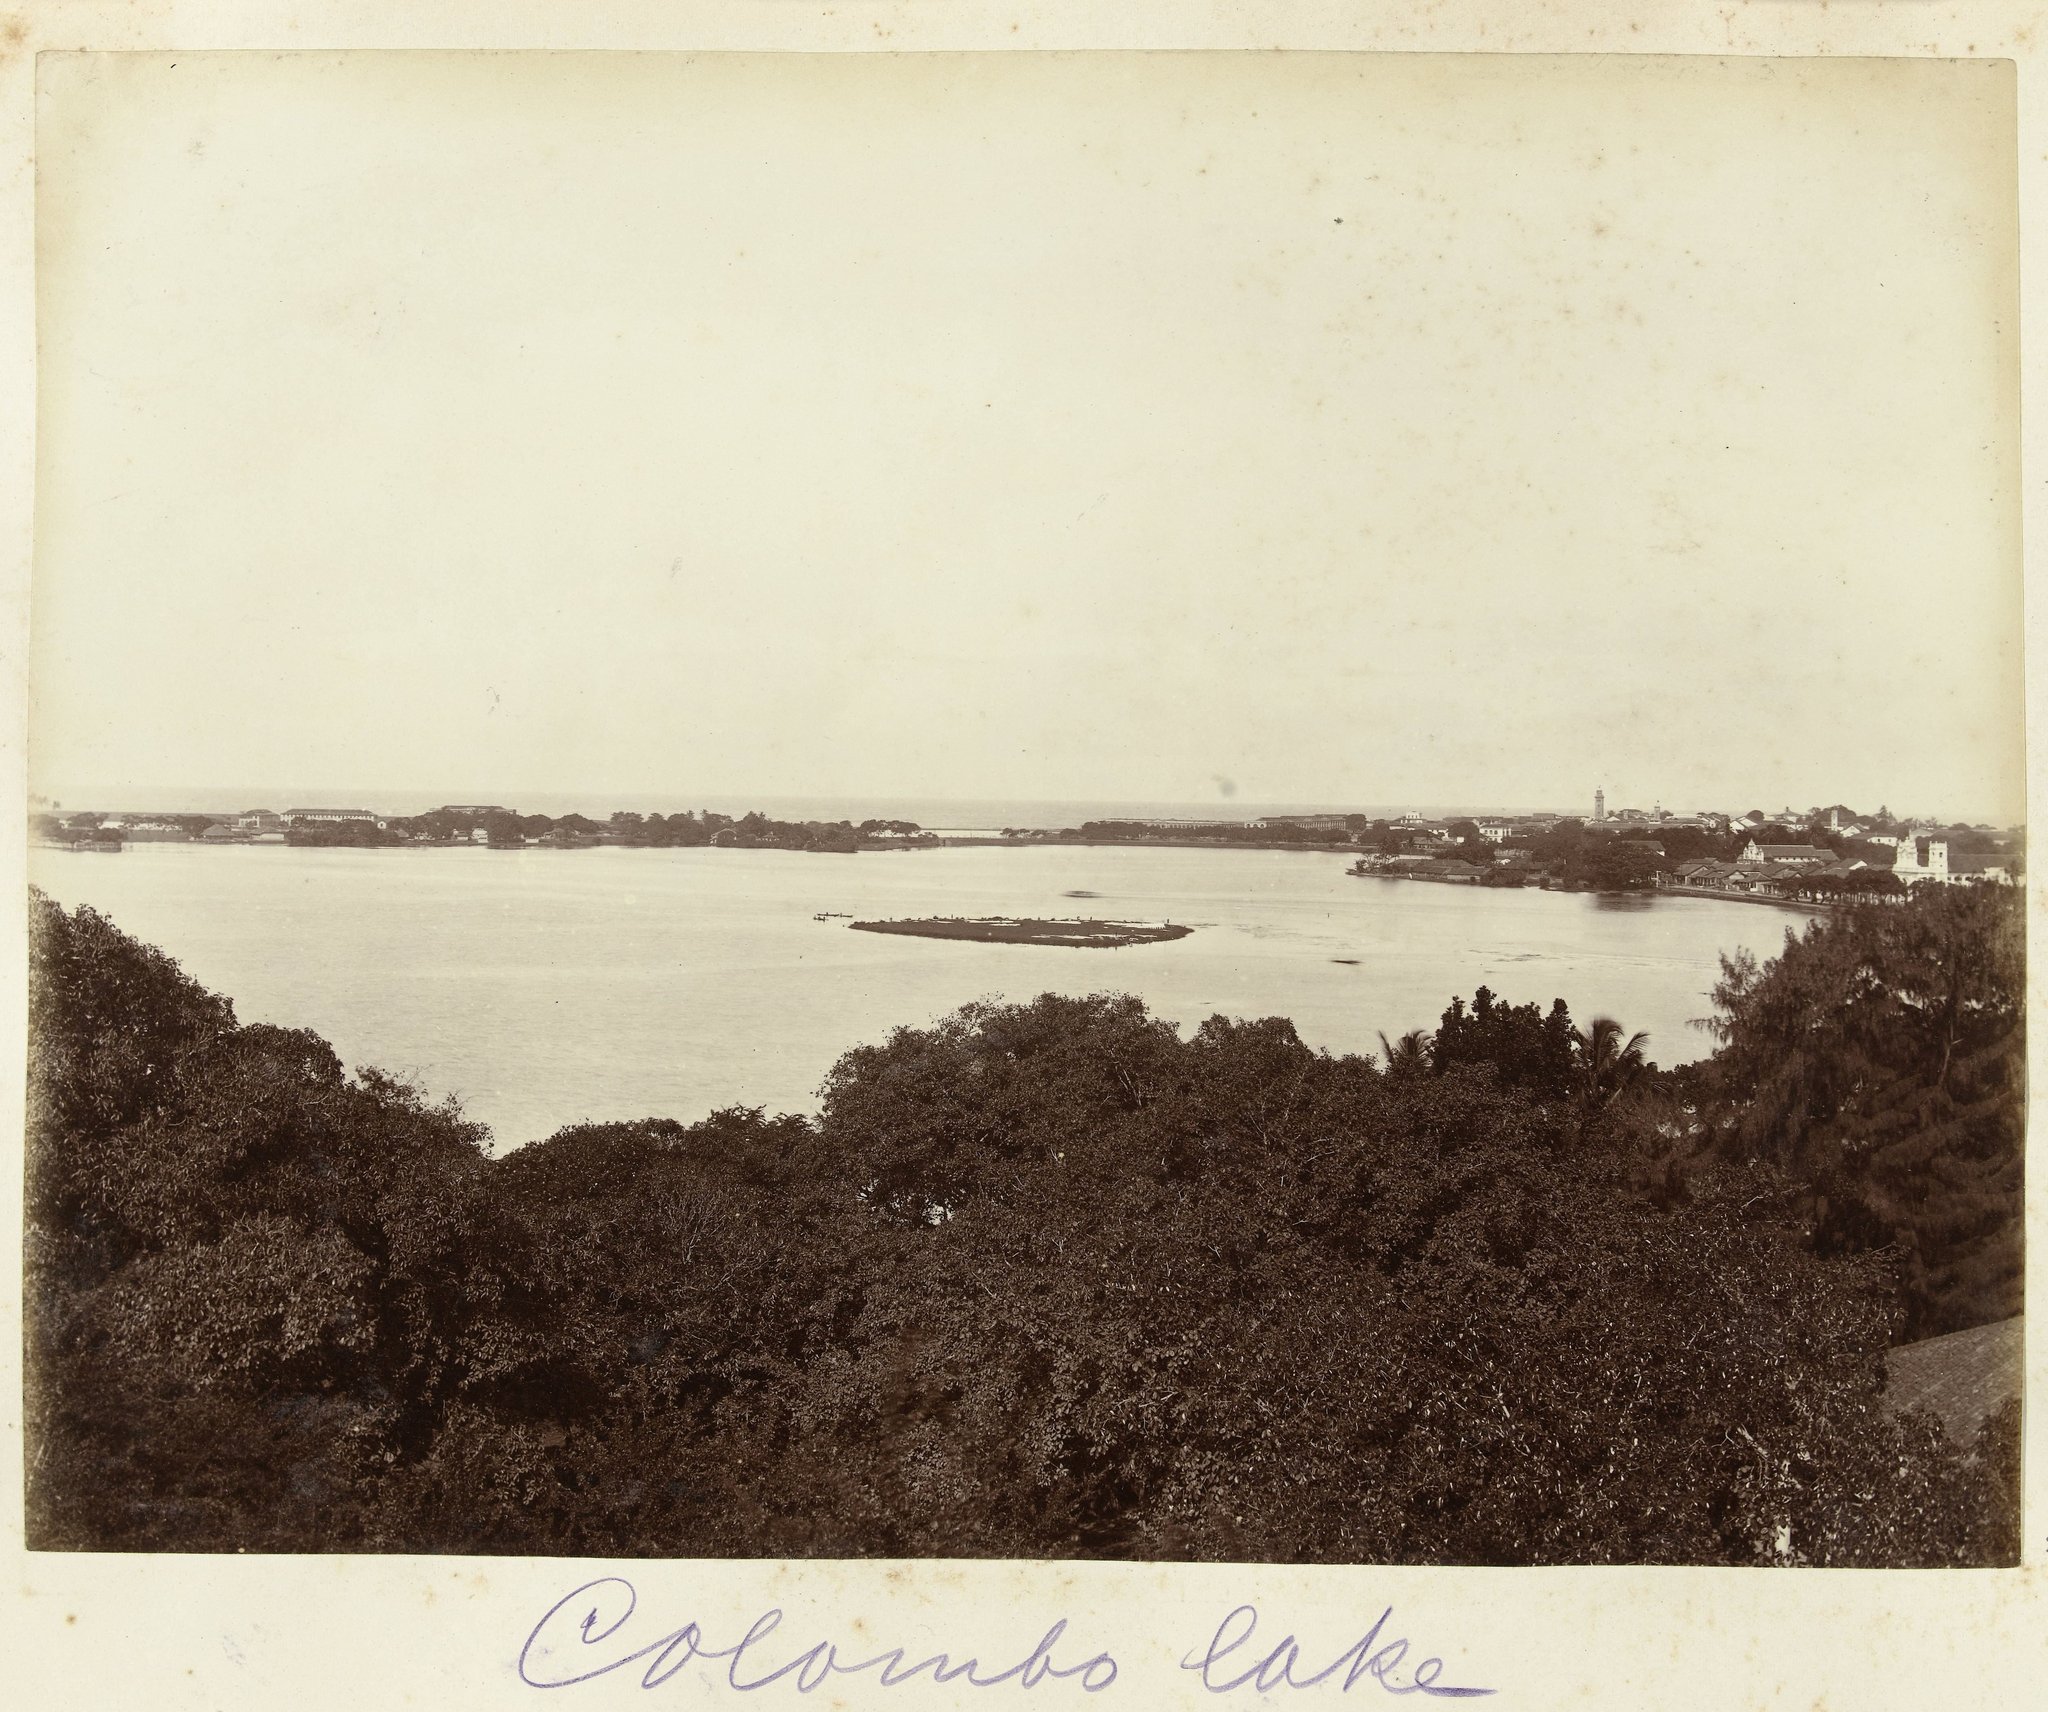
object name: photograph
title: Colombo lake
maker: Anonymous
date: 1890-1910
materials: cardboard, paper, photographic support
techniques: gelatin silver print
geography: colombo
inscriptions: caption: ‘Colombo lake’